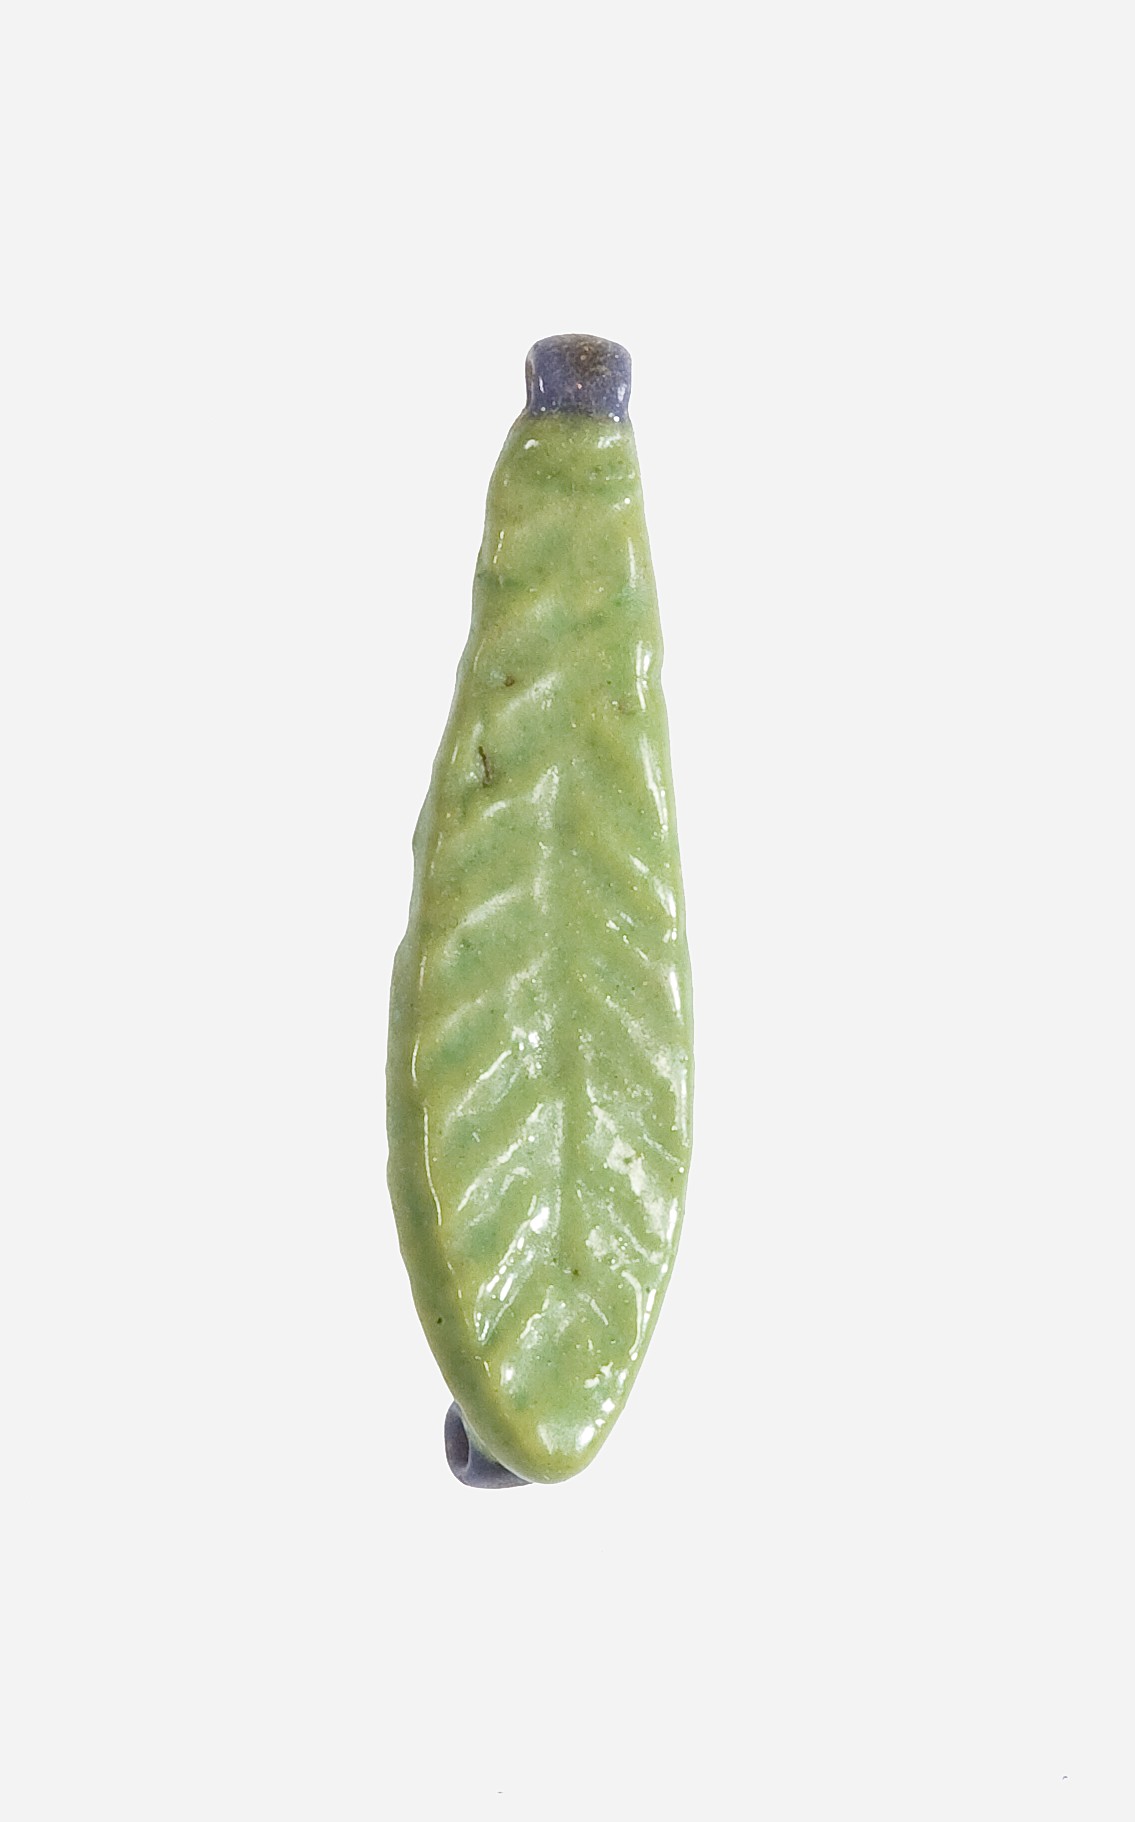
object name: bead, leaf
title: Leaf Bead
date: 1390-1352 BCE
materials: faience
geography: egypt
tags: leaves